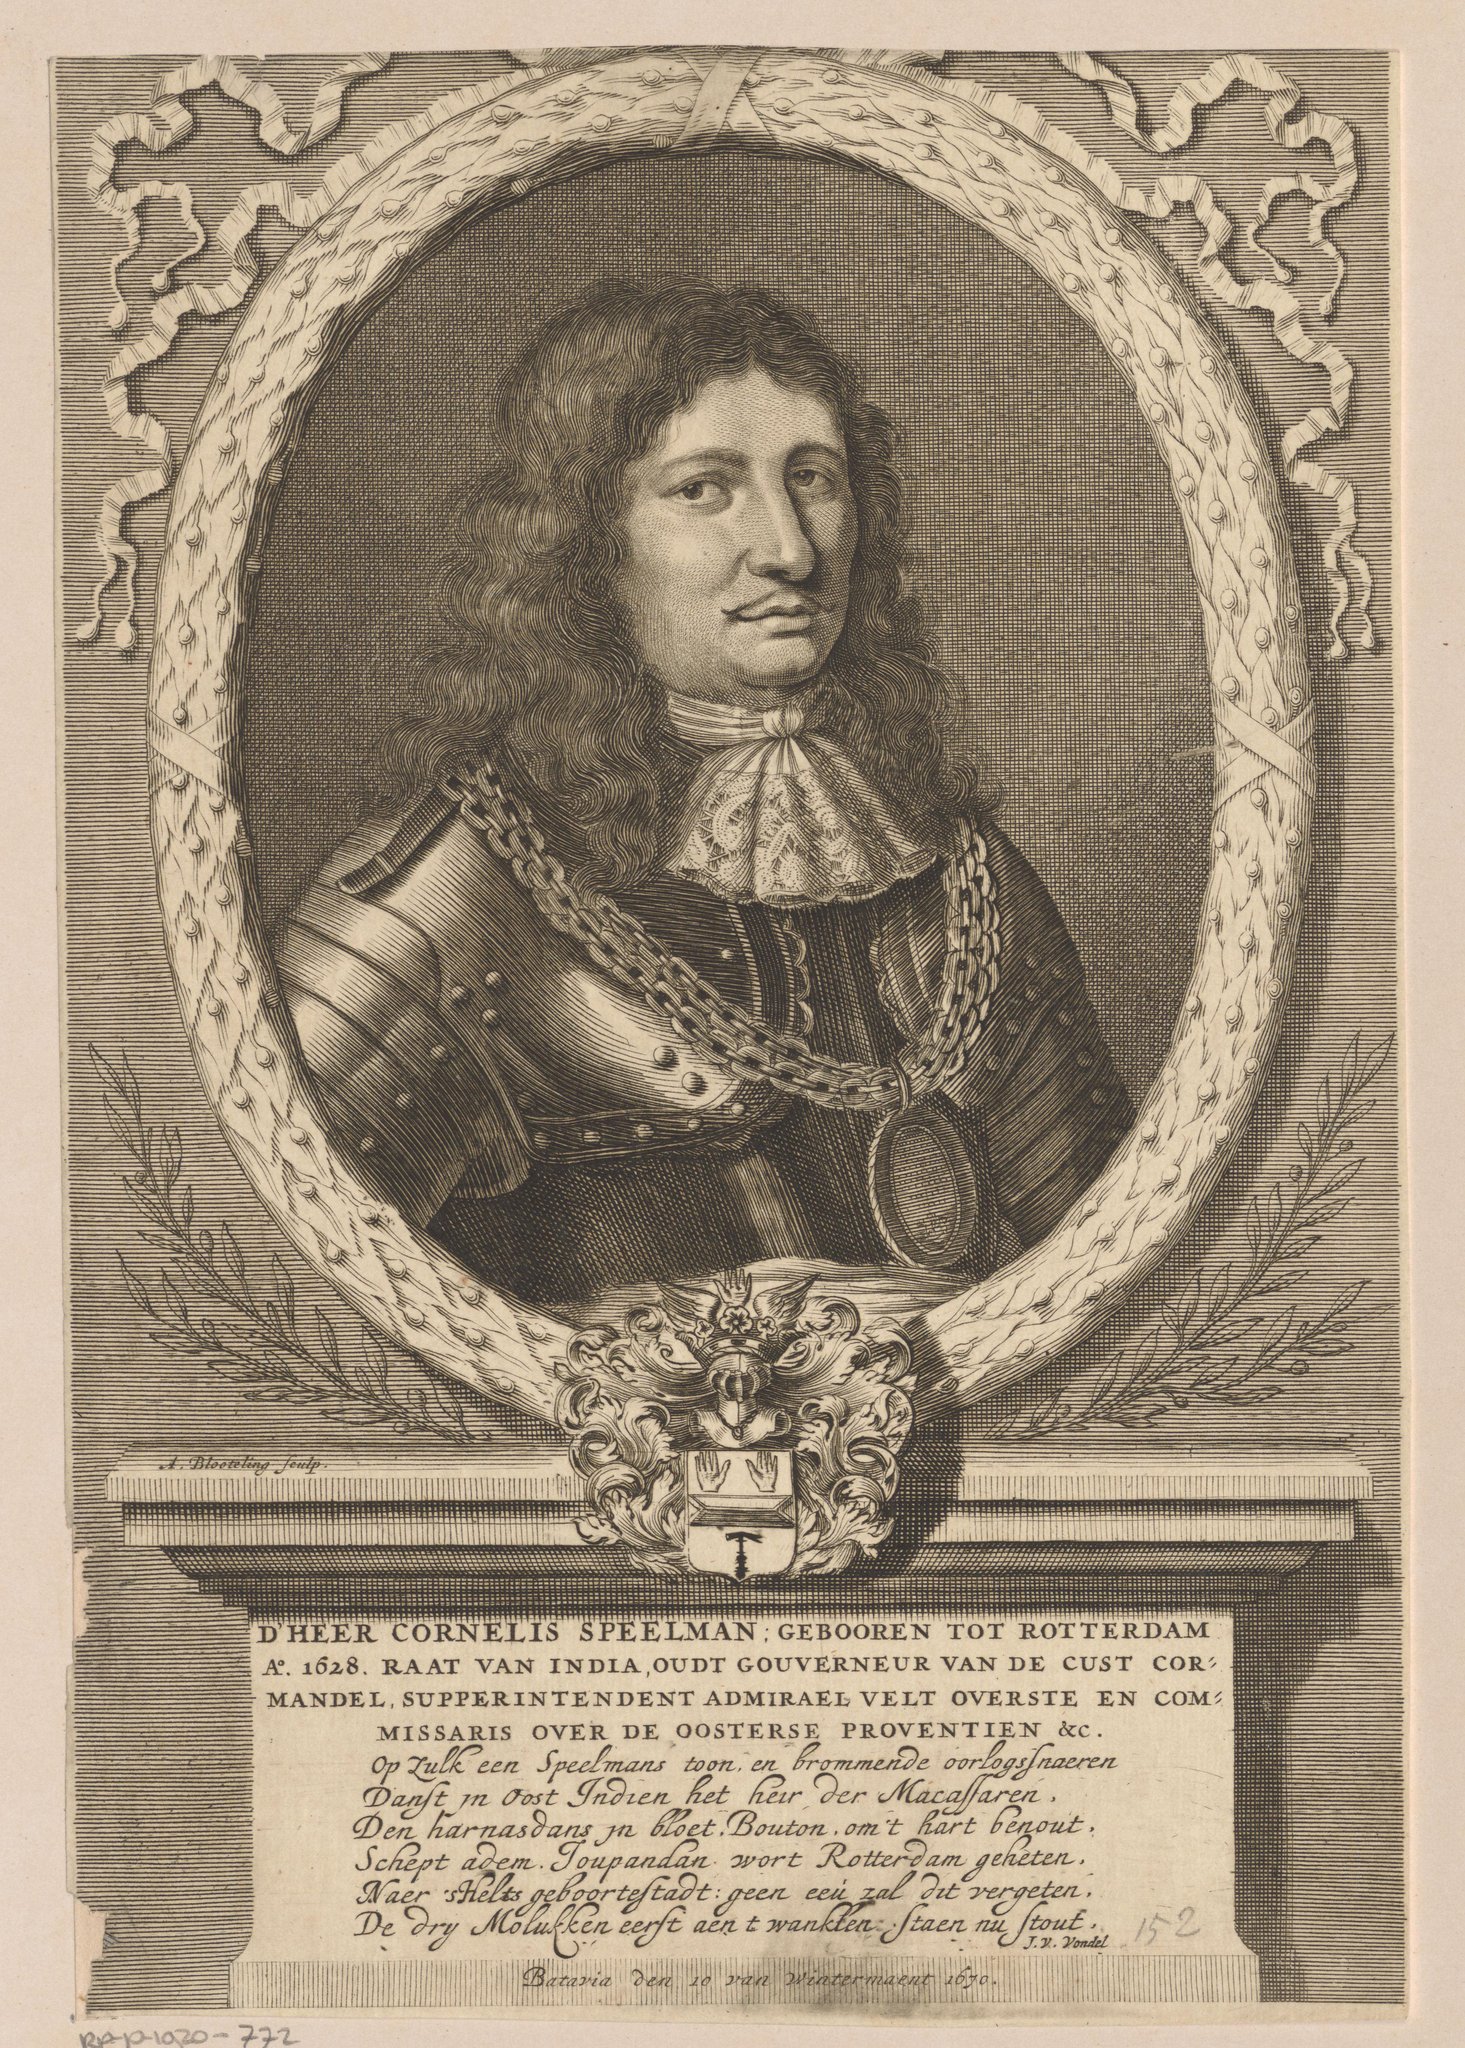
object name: print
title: Portret van Cornelis Speelman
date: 1670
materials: paper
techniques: engraving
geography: amsterdam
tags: rotterdam, batavia, colonial governor, historical persons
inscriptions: collector's mark: Lugt 2228, inscription: ‘G.G. 1681 - 1684’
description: Met tienregelig onderschrift in het Nederlands.